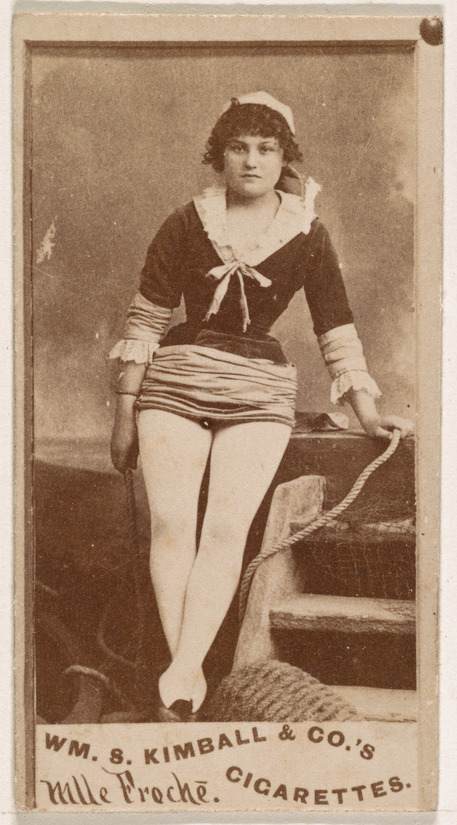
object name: photograph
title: Mlle. Froche, from the Actresses series (N203) issued by Wm. S. Kimball & Co.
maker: william s. kimball & company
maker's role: publisher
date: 1889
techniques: color lithograph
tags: portraits,women,actresses